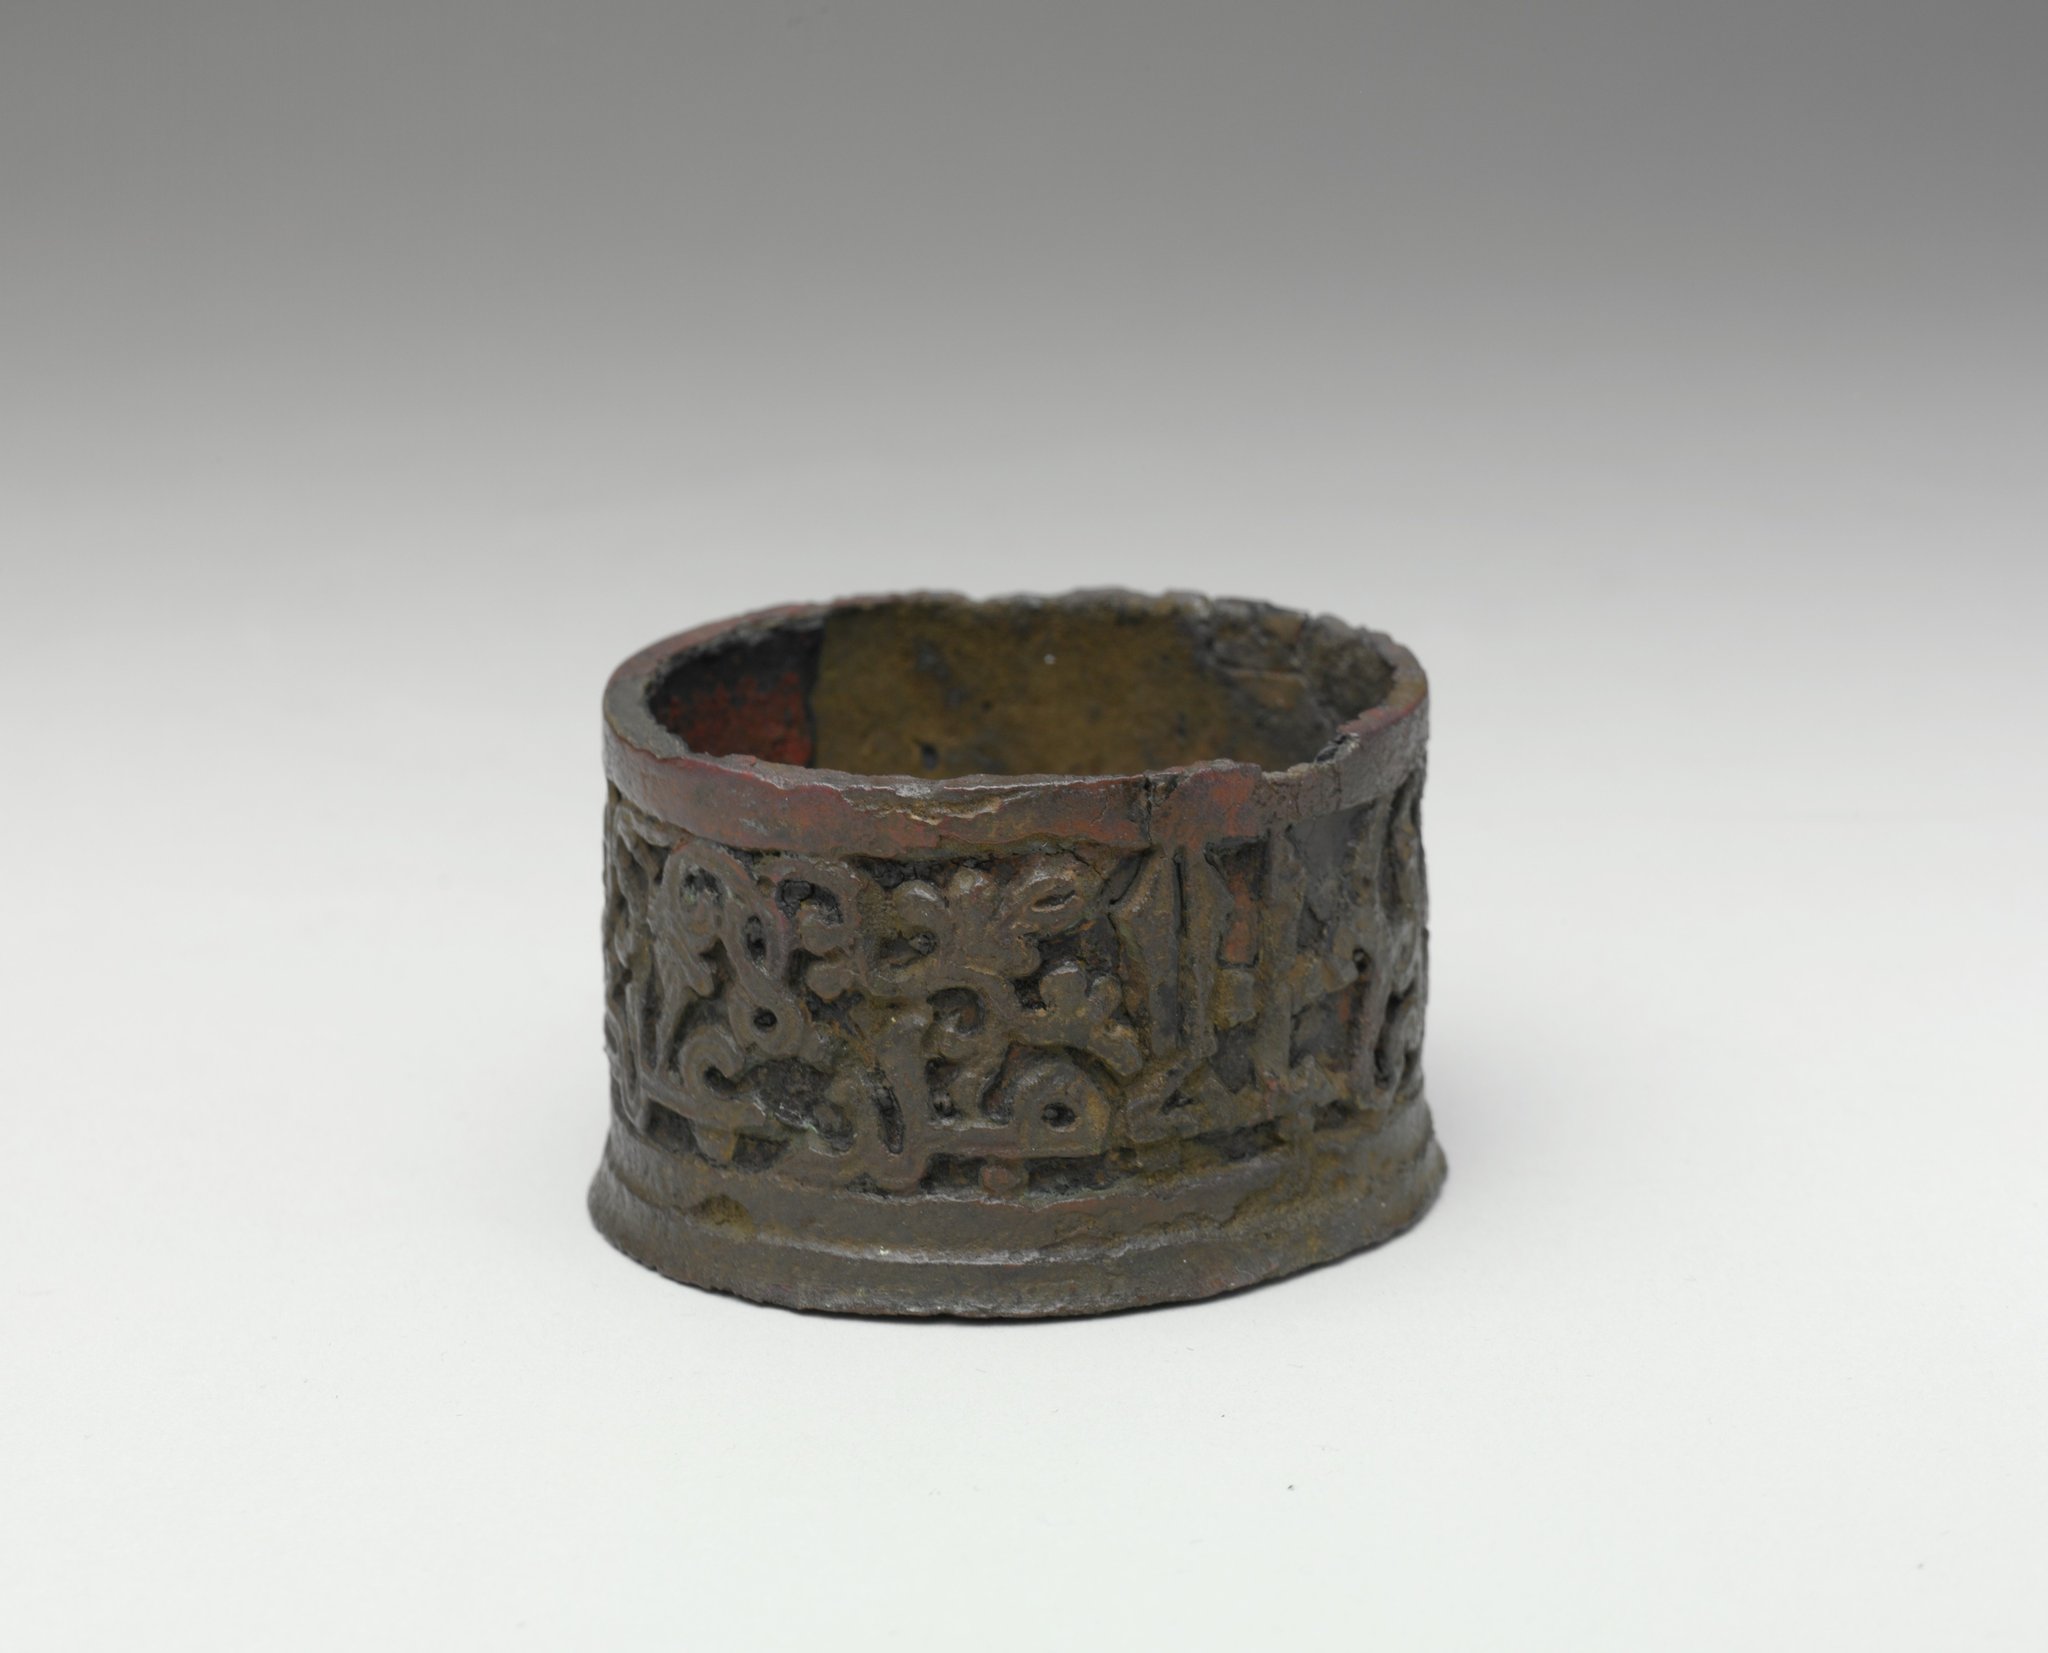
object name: box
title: Inkwell with the Name of Amir 'Abdullah ibn al-Hasan Pars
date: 1001-1100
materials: bronze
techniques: casting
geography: iran